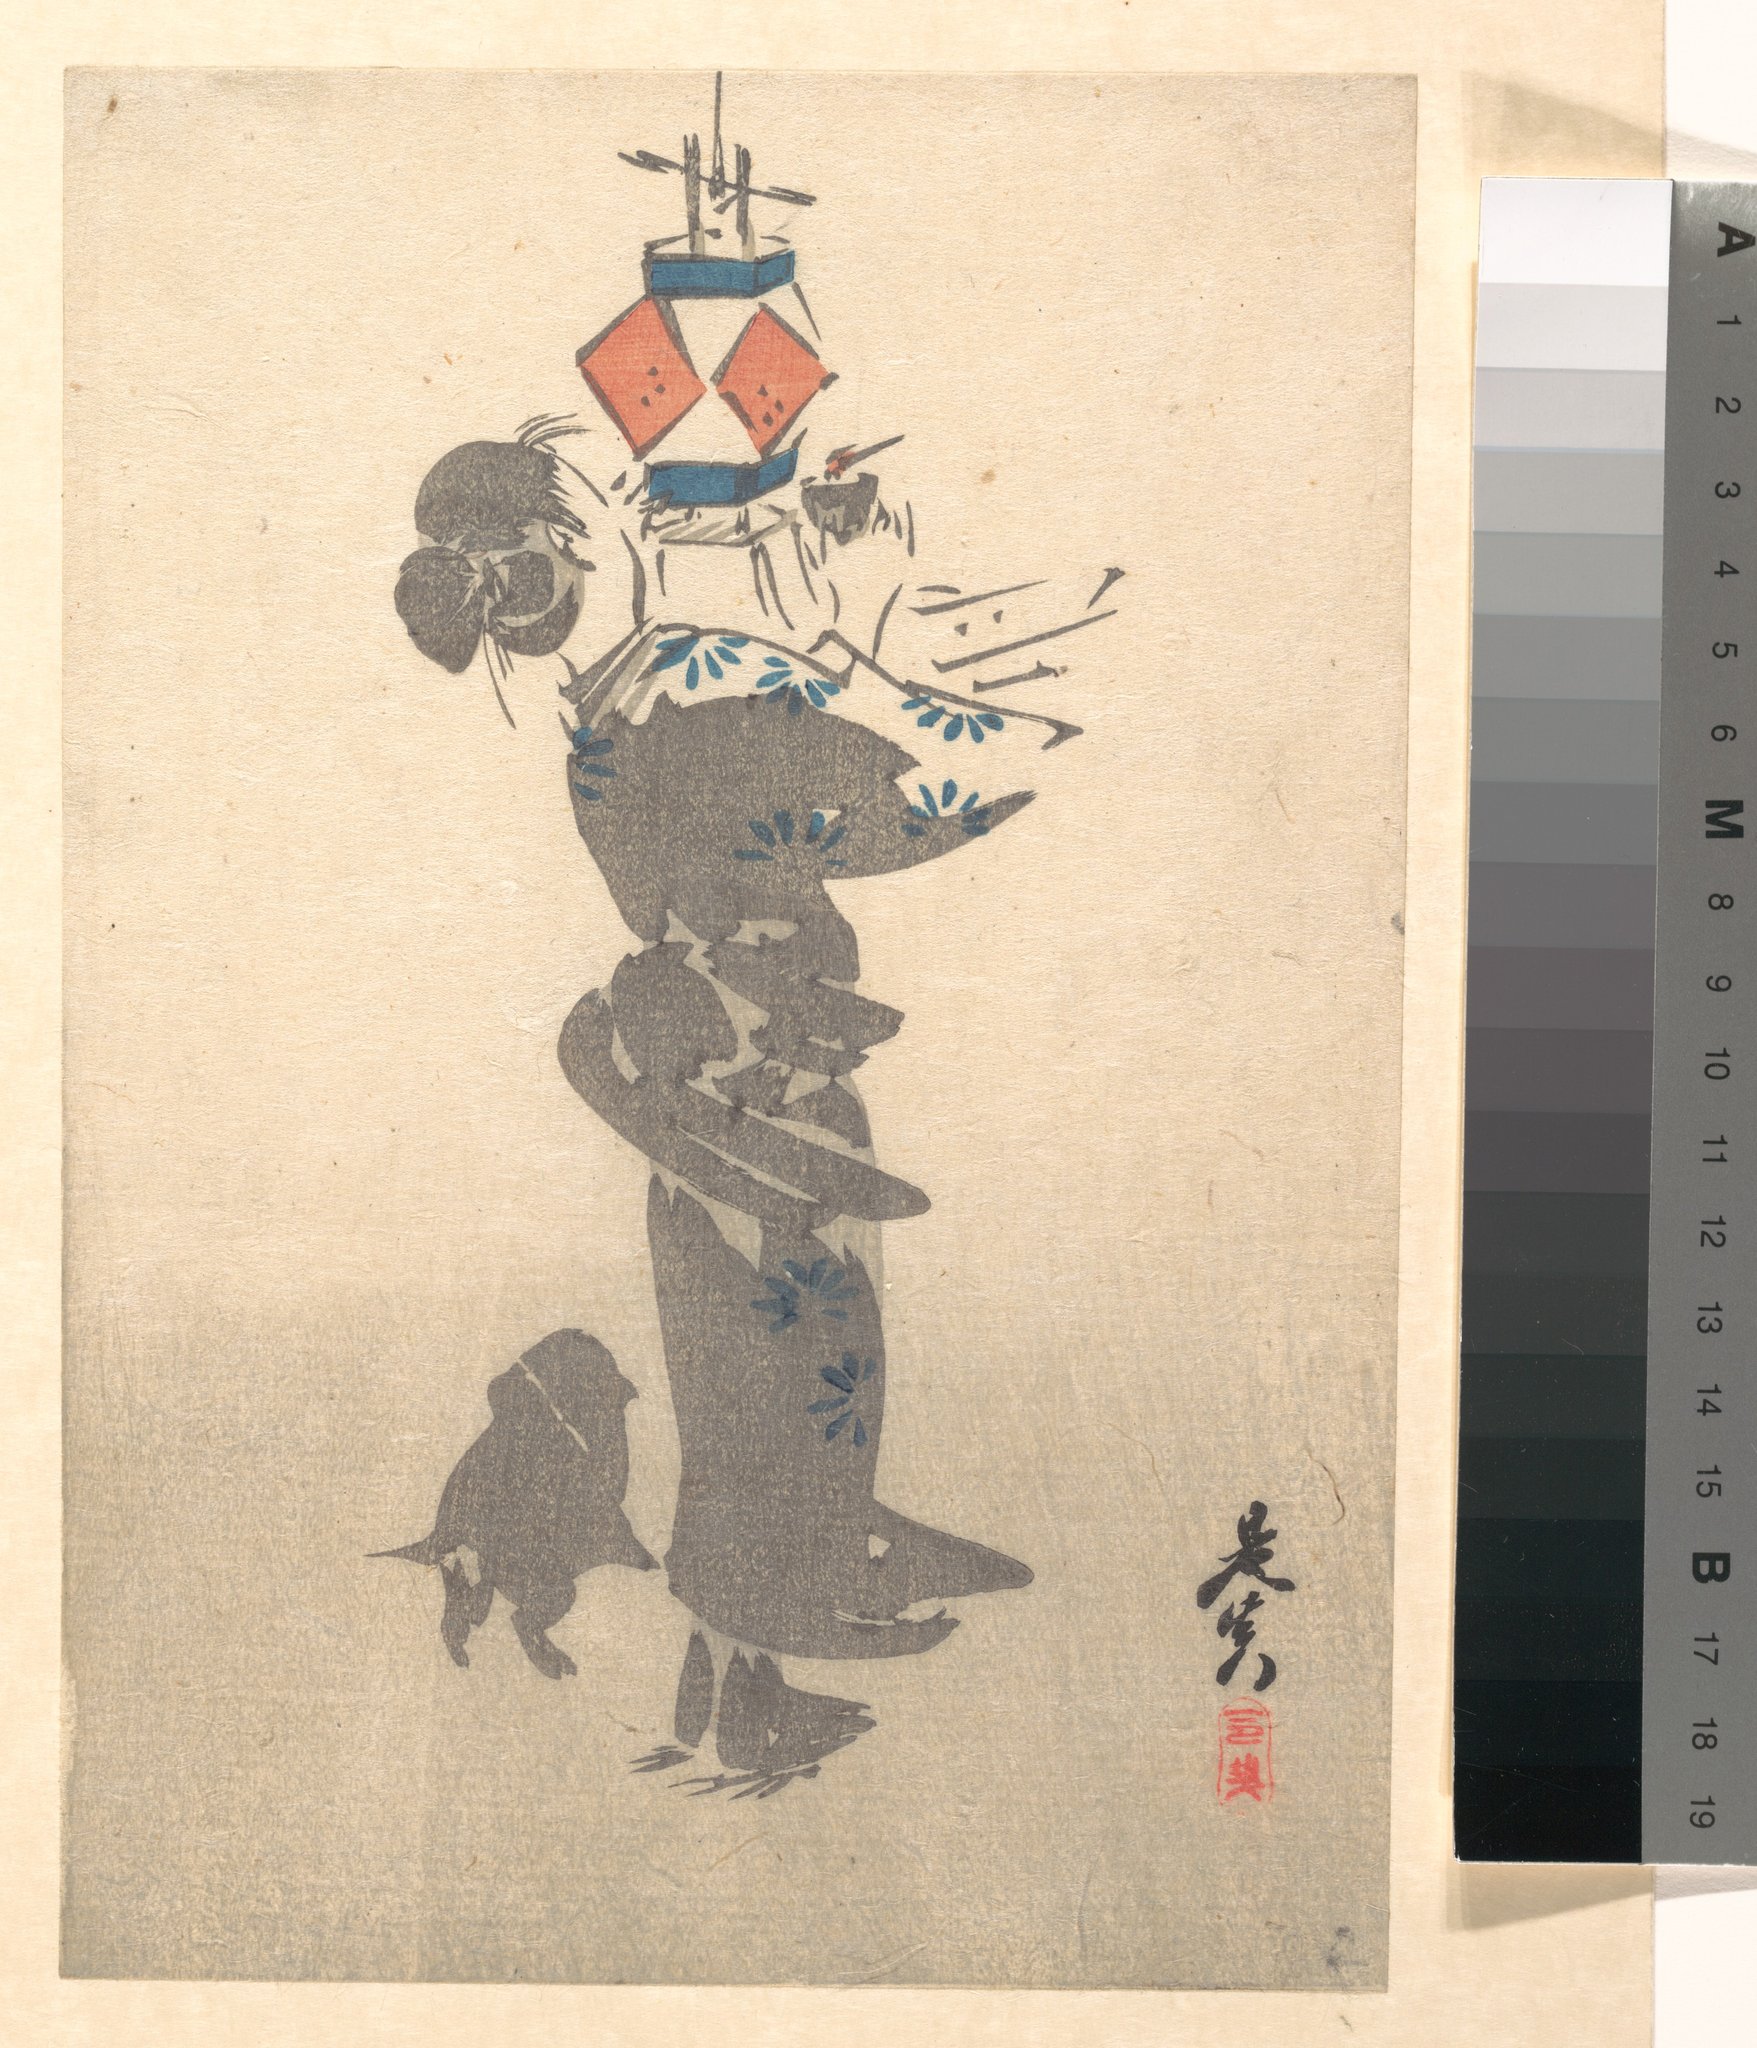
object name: woodblock print nishiki e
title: Lighting a Hanging Lantern for the Obon Festival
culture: japanese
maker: shibata zeshin 柴田是真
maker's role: artist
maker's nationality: japanese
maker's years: 1807-1891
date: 1860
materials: ink, paper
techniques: nishiki e, woodblock print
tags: women,dogs,lanterns